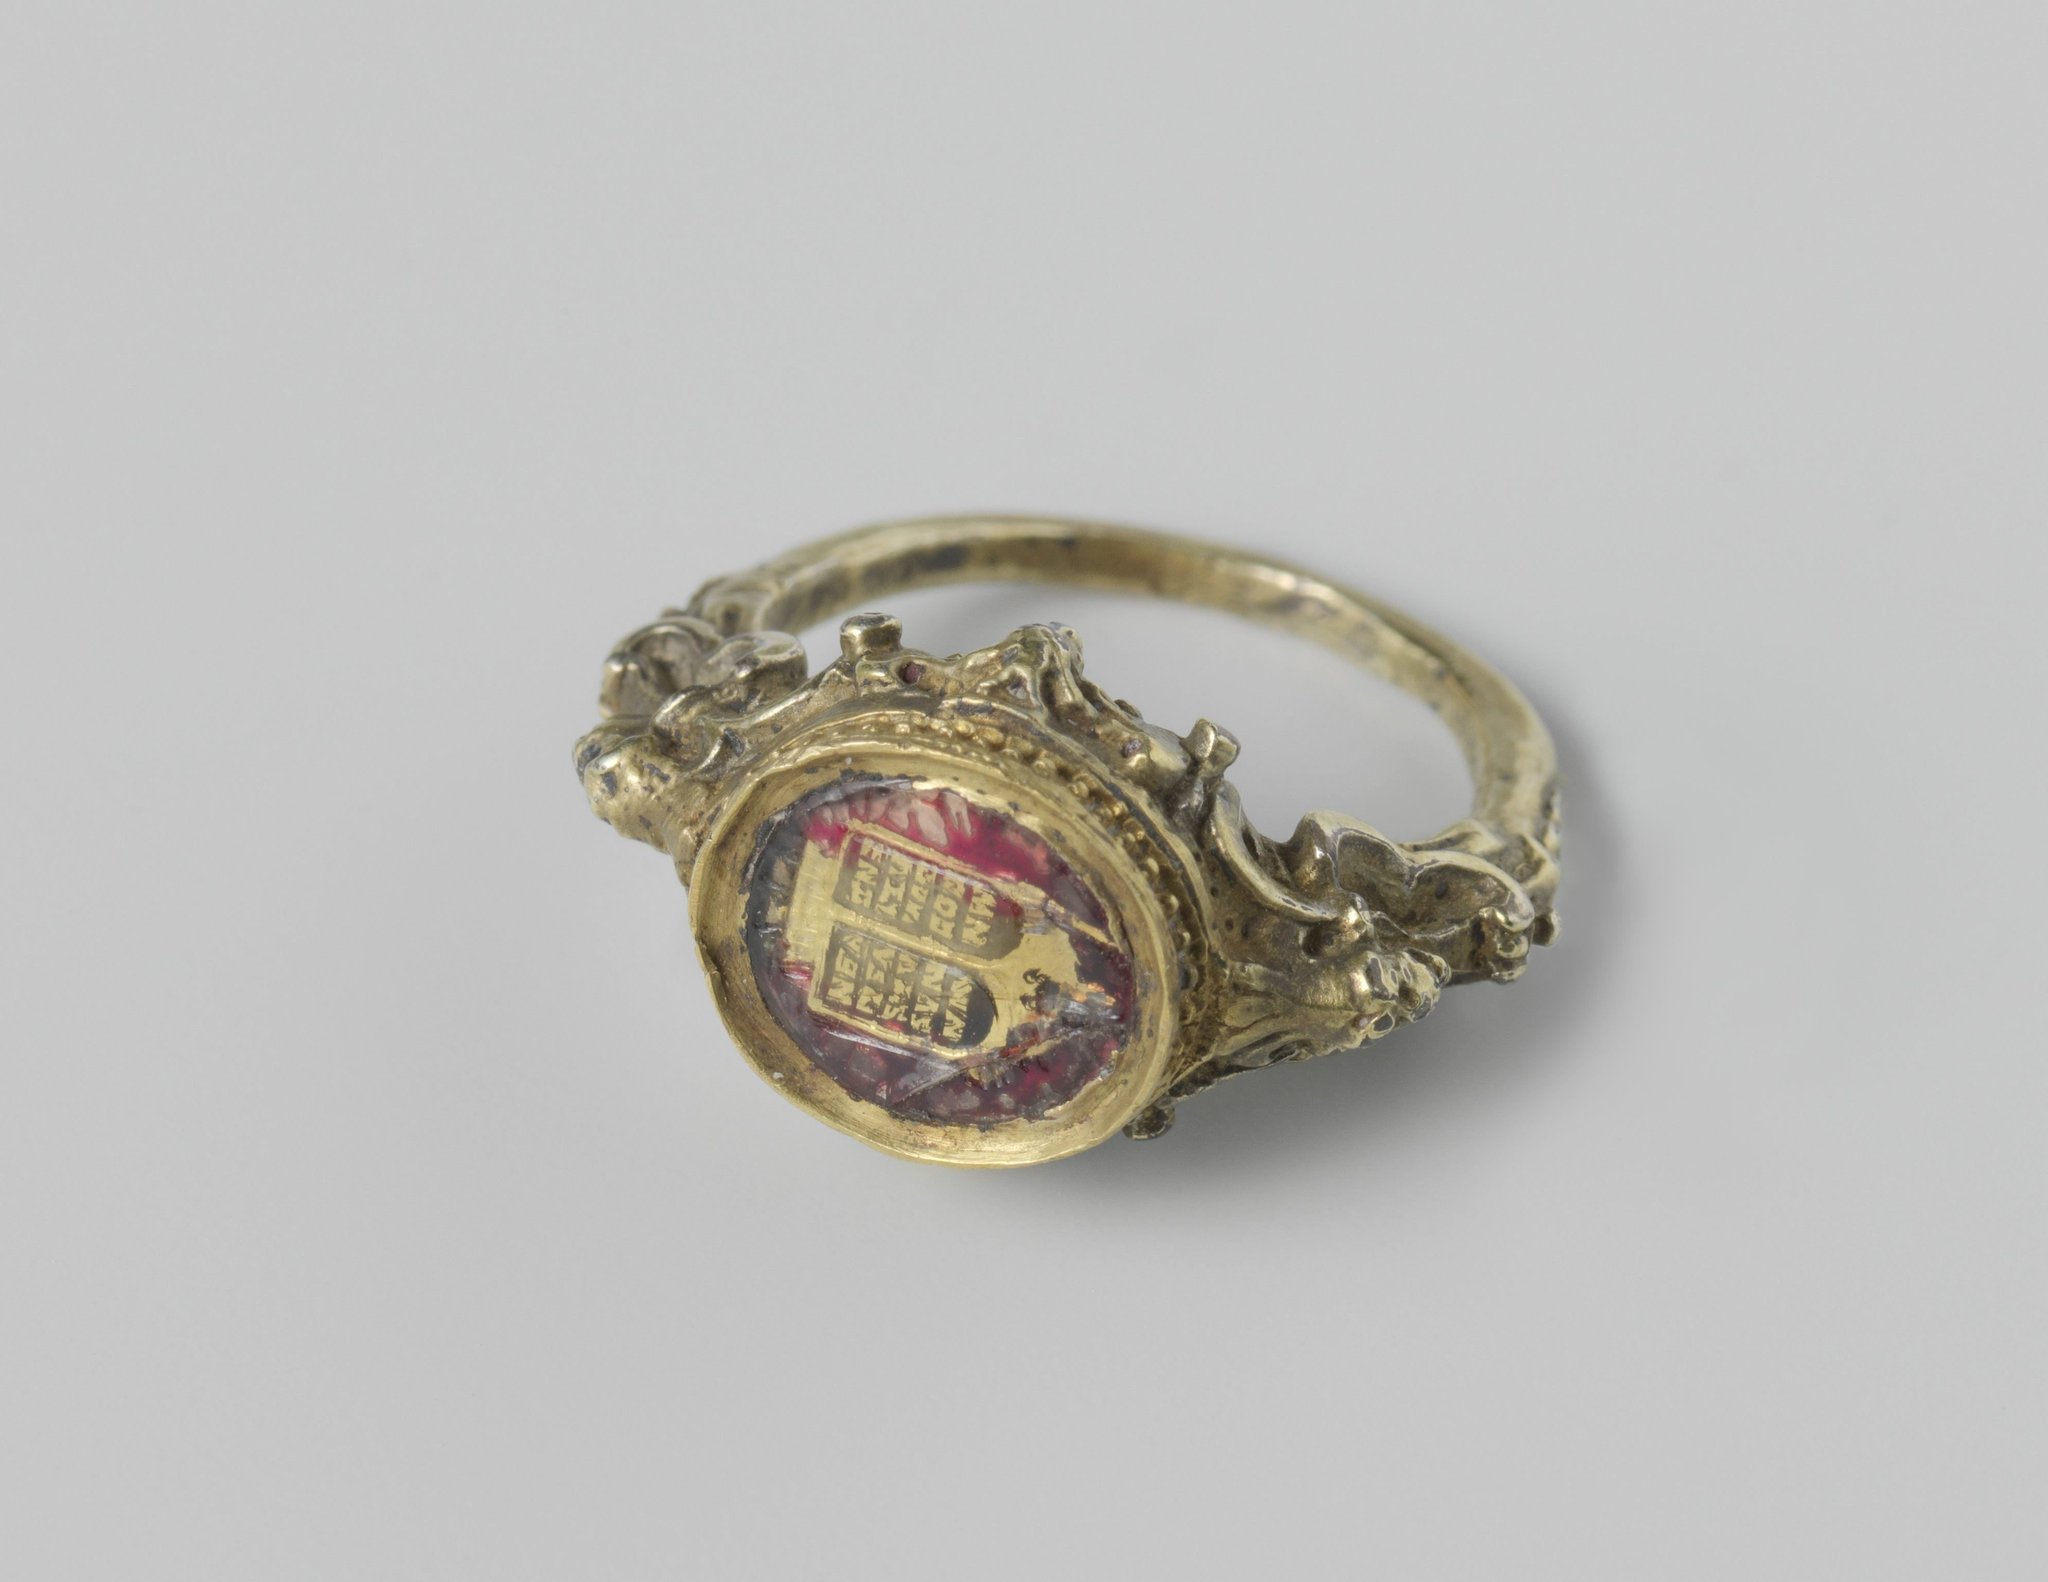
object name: ring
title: Ring gedecoreerd met Mozes en de wetstafelen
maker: Anonymous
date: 1570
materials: silver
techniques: gilding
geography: netherlands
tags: moses (not in biblical context); possible attributes: rays of light or horns on his head, rod, tables of the law, the ten commandments represented together on stone tablets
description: Ring. Moses and the tables of the Law. Silver-gilt, rock crystal and foil. Netherlands, ca 1570.